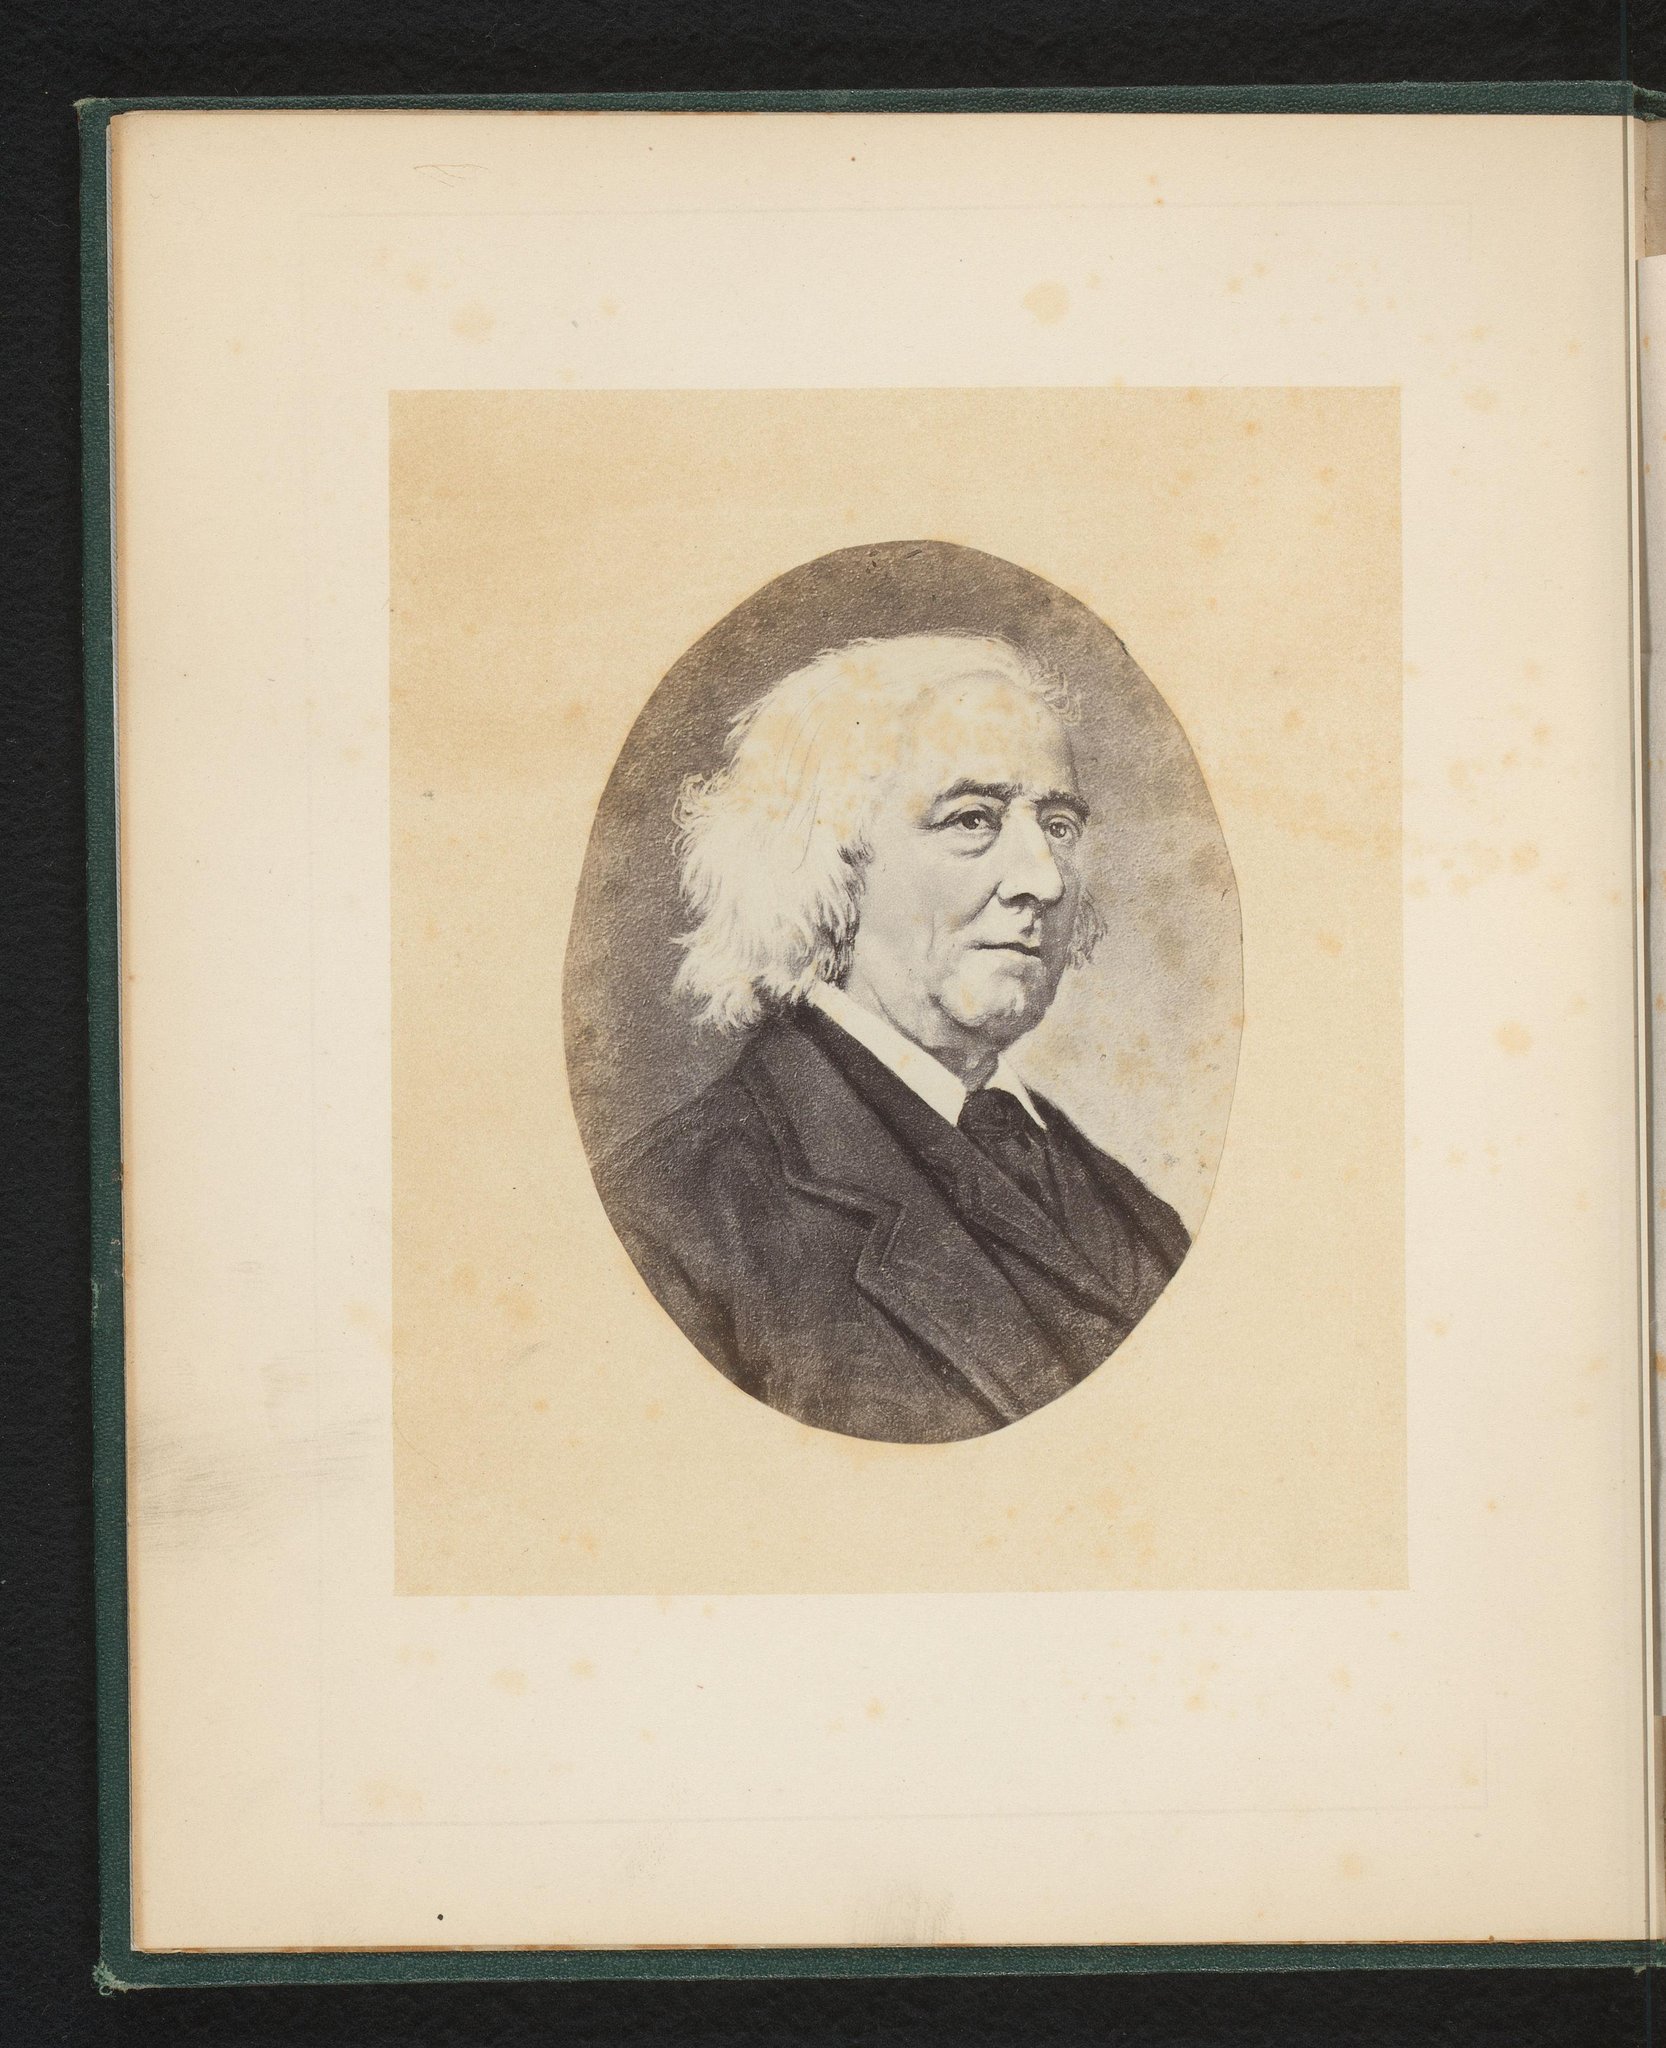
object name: photograph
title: Fotoreproductie van een geschilderd portret van Jacob Van Lennep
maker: Anonymous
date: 1870-1880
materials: paper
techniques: albumen print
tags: amsterdam, jacob van lennep, portrait of a writer